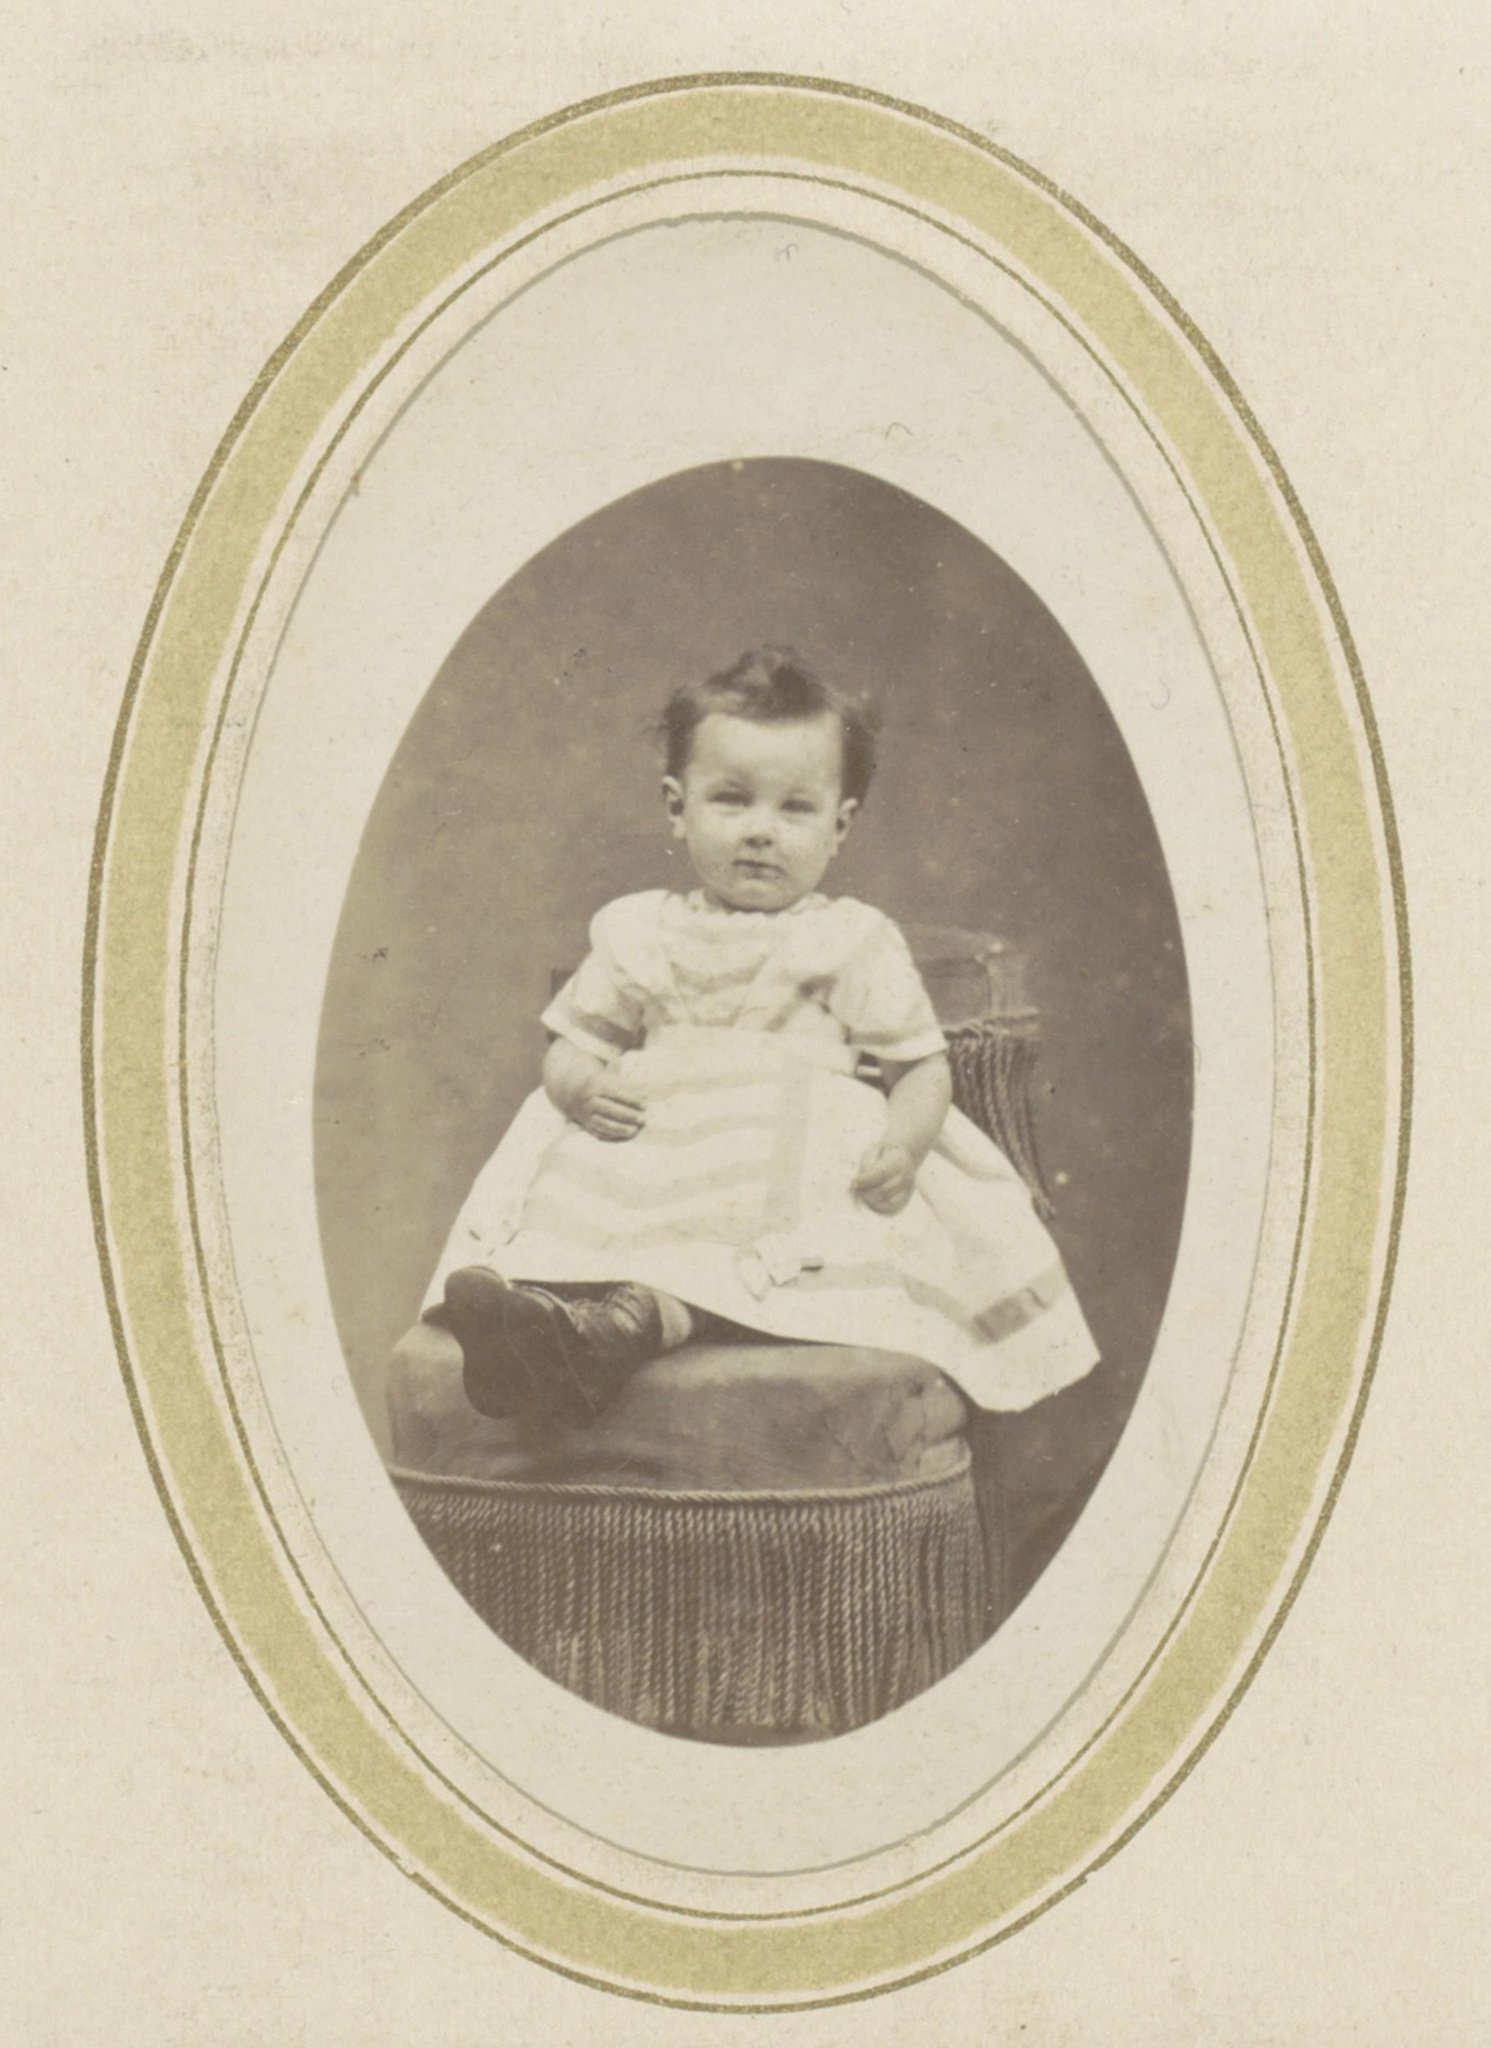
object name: carte de visite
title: Portret van een peuter in een gestreepte jurk op een fauteuil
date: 1863-1880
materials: cardboard, paper, photographic support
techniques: albumen print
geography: utrecht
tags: historical persons, clothes covering the entire body, tot, toddler ~ the ages of man, utrecht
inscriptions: address: ‘Utrecht Zonstraat Wijk G. No. 401’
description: Onderdeel van Fotoalbum van een Nederlandse familie met 168 cartes-de-visite en kabinetfoto's.